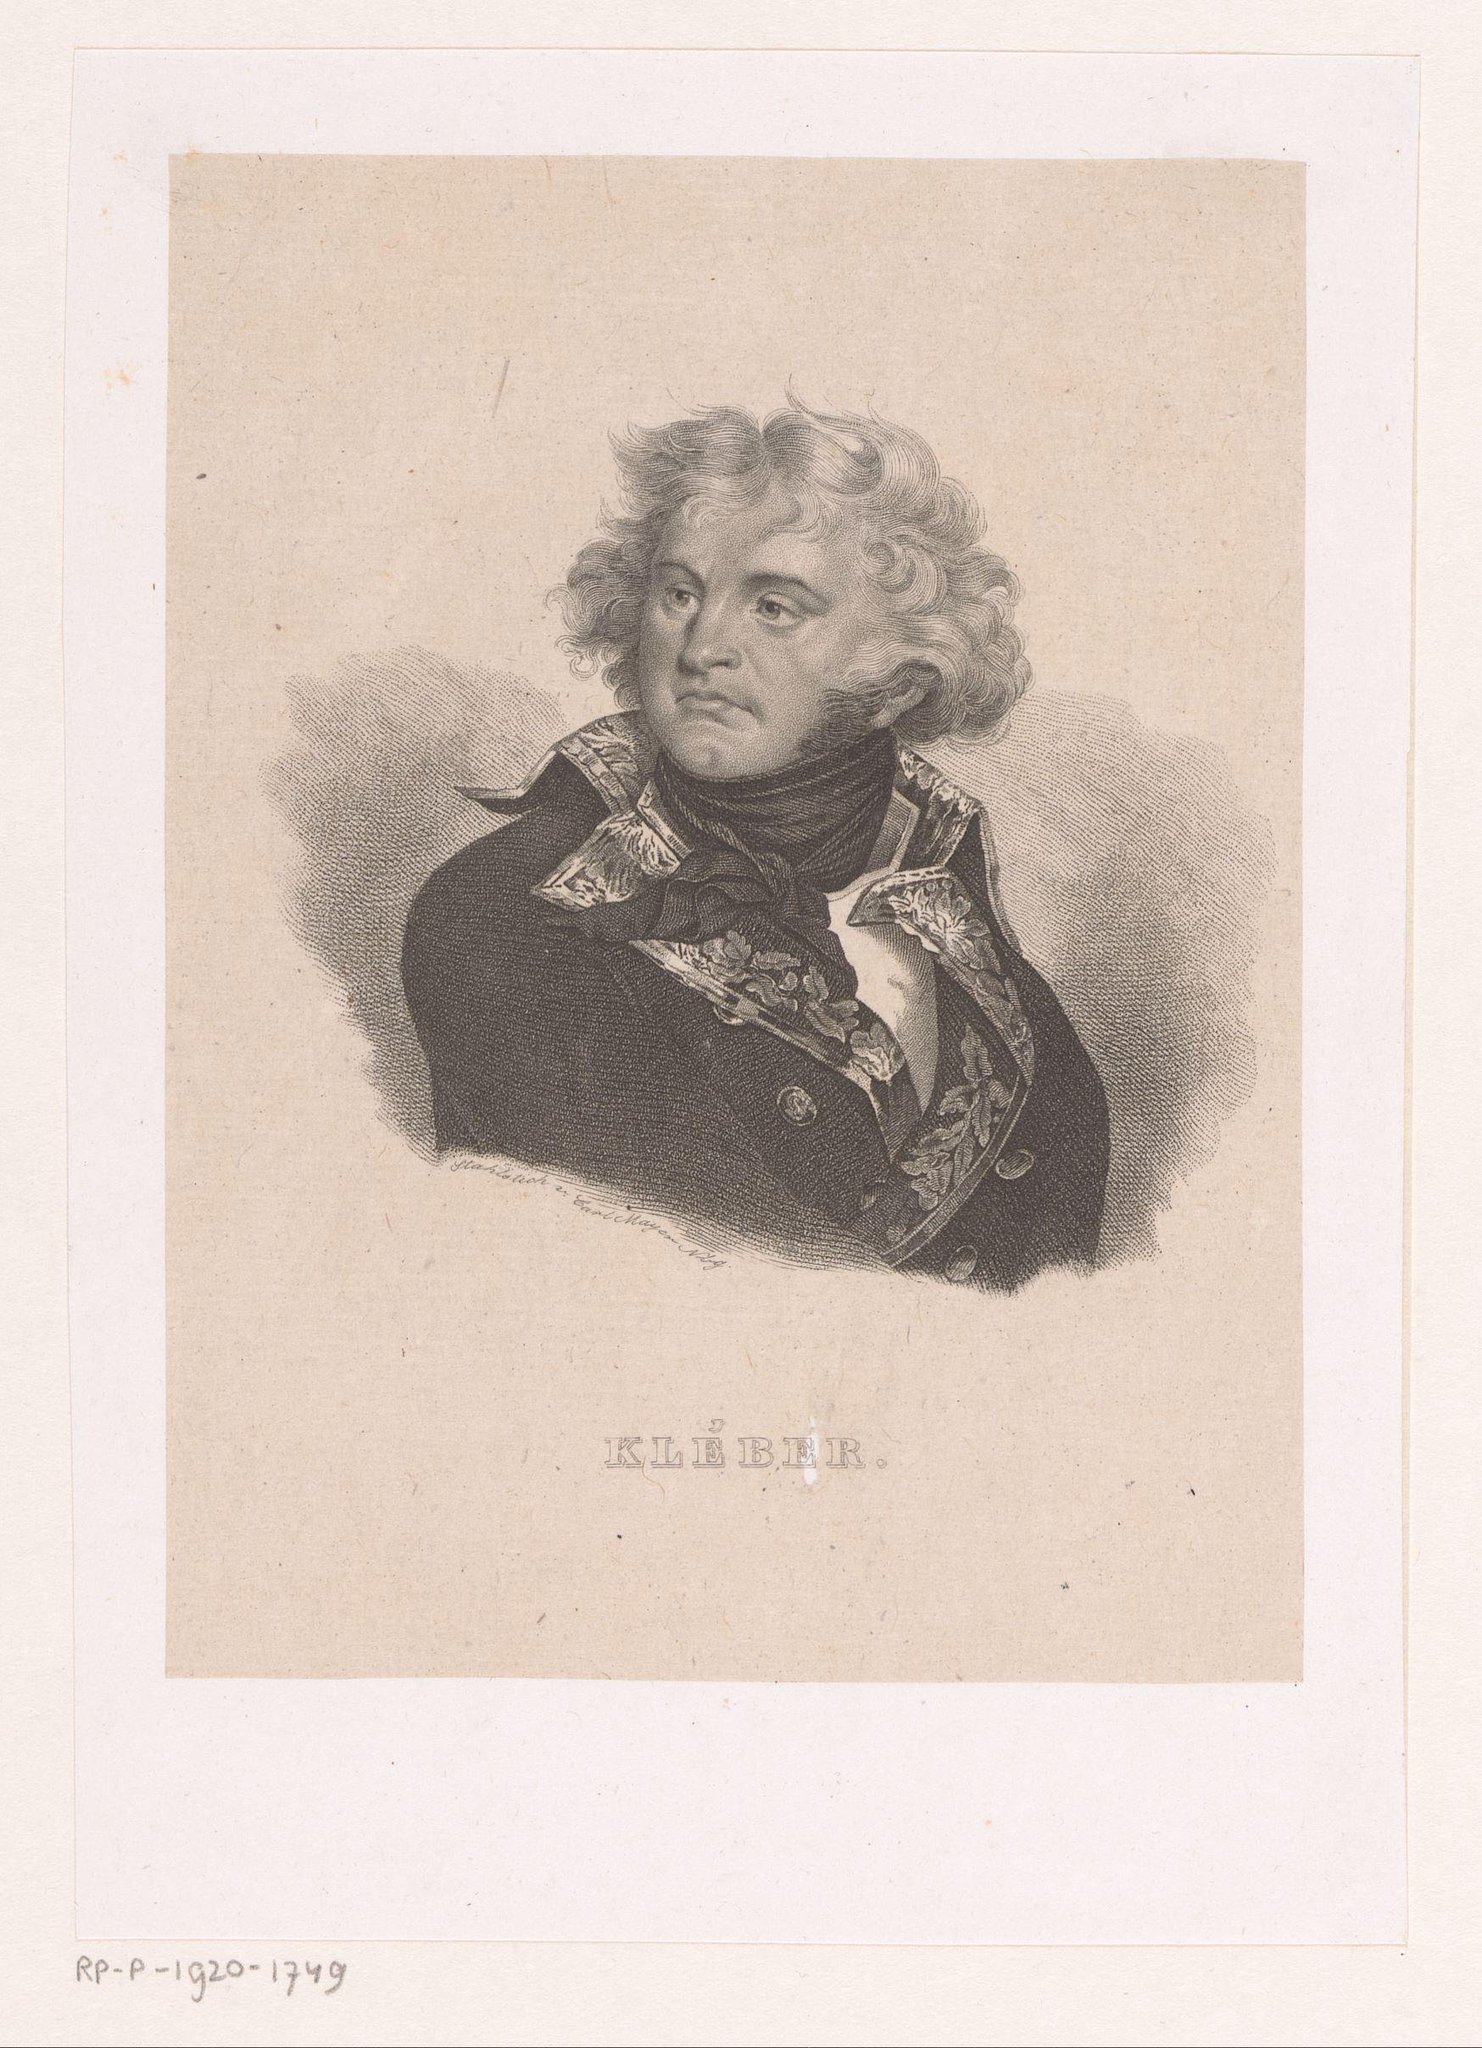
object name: print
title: Portret van Jean-Baptiste Kléber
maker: carl mayer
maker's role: print maker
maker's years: 1798-1868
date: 1808-1868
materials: paper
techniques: engraving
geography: nuremberg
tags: historical persons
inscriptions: collector's mark: Lugt 2228